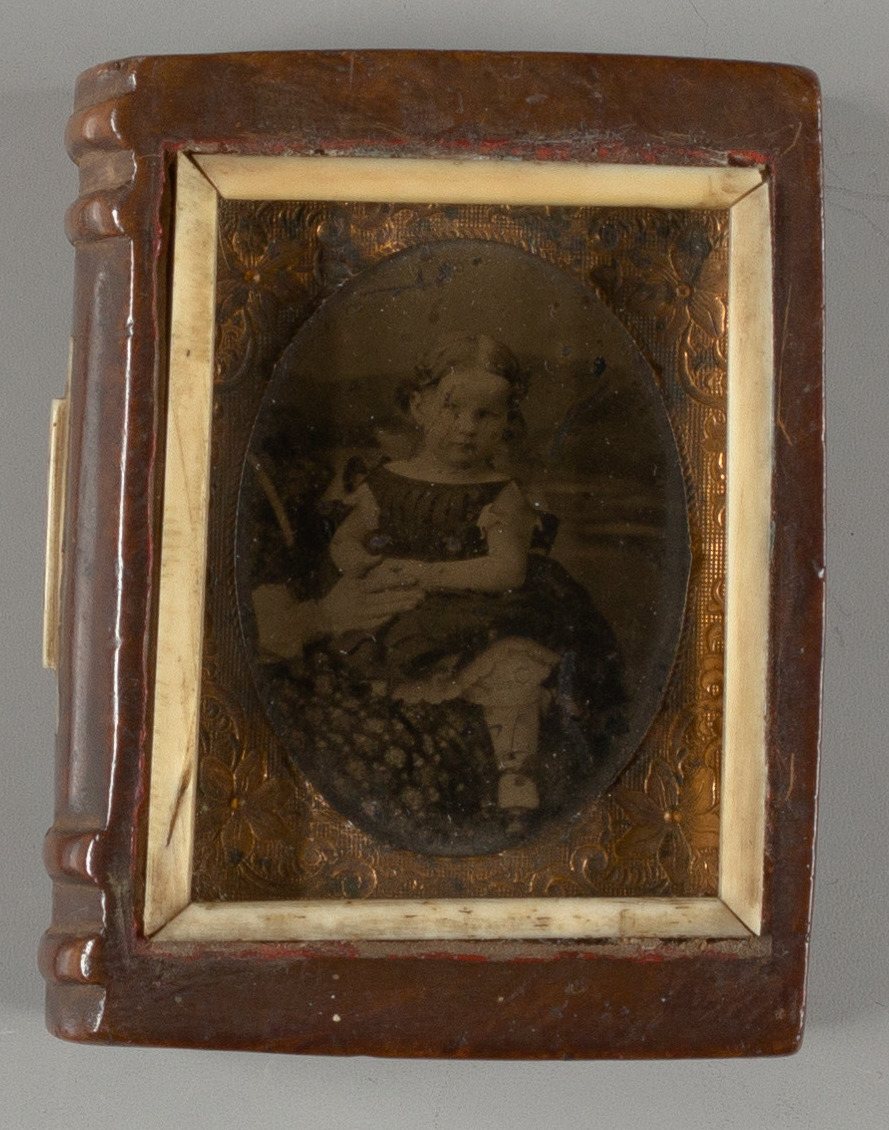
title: Memento in book form, with photograph of a child and initials I.C.H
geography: england